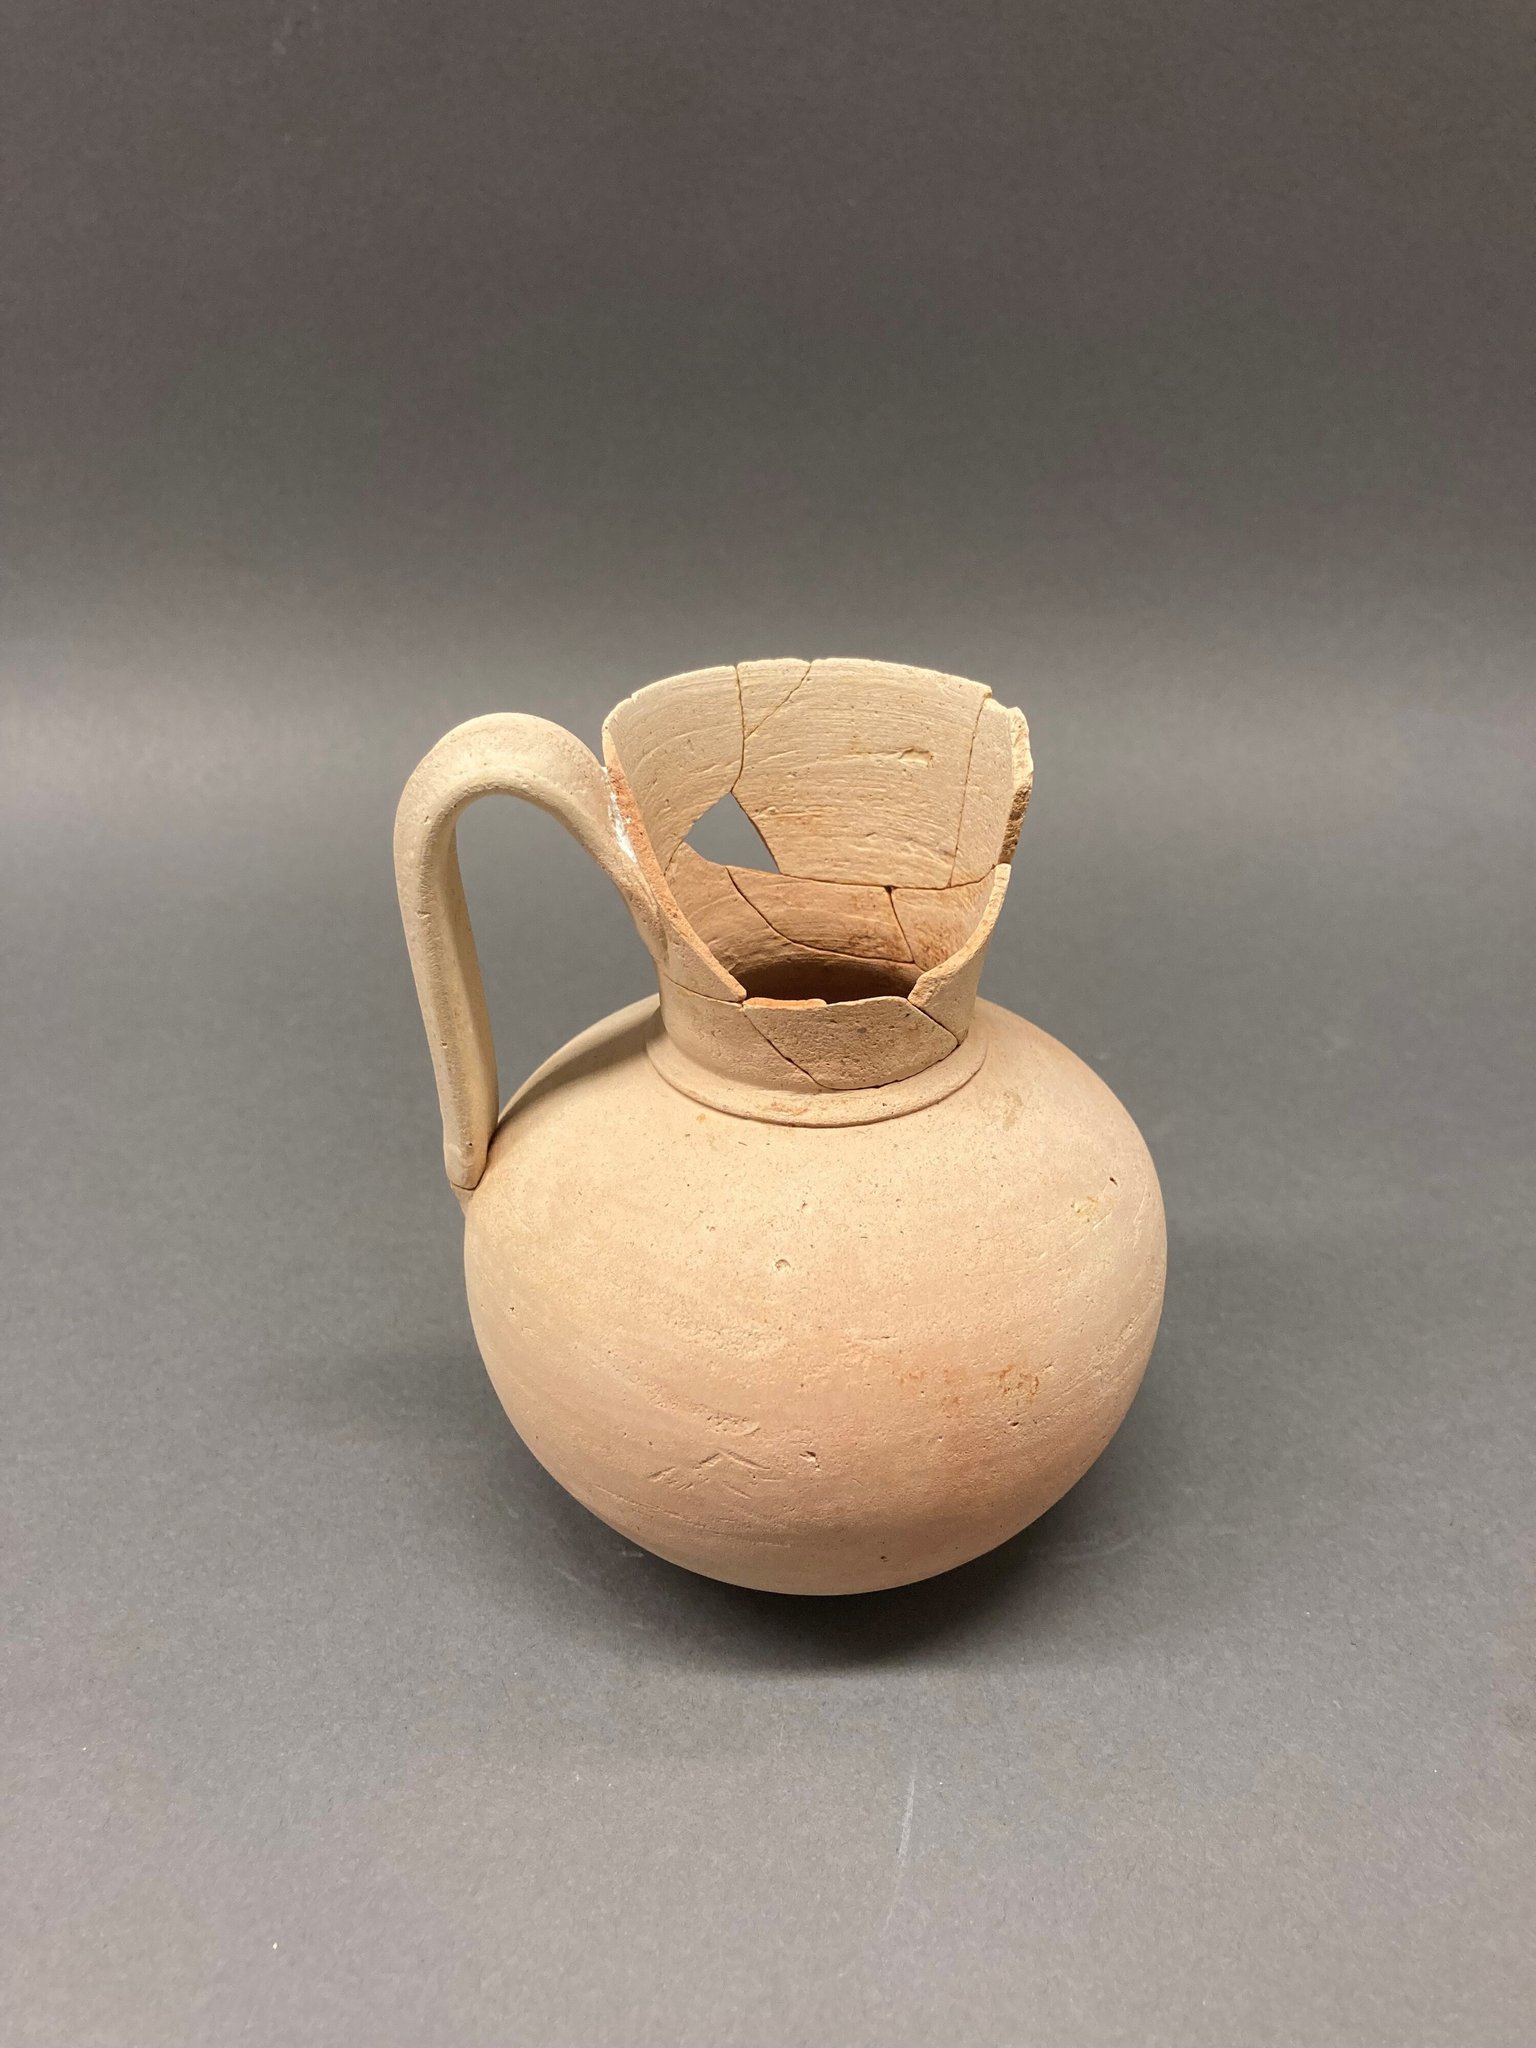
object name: ewer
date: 801-900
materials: earthenware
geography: iran